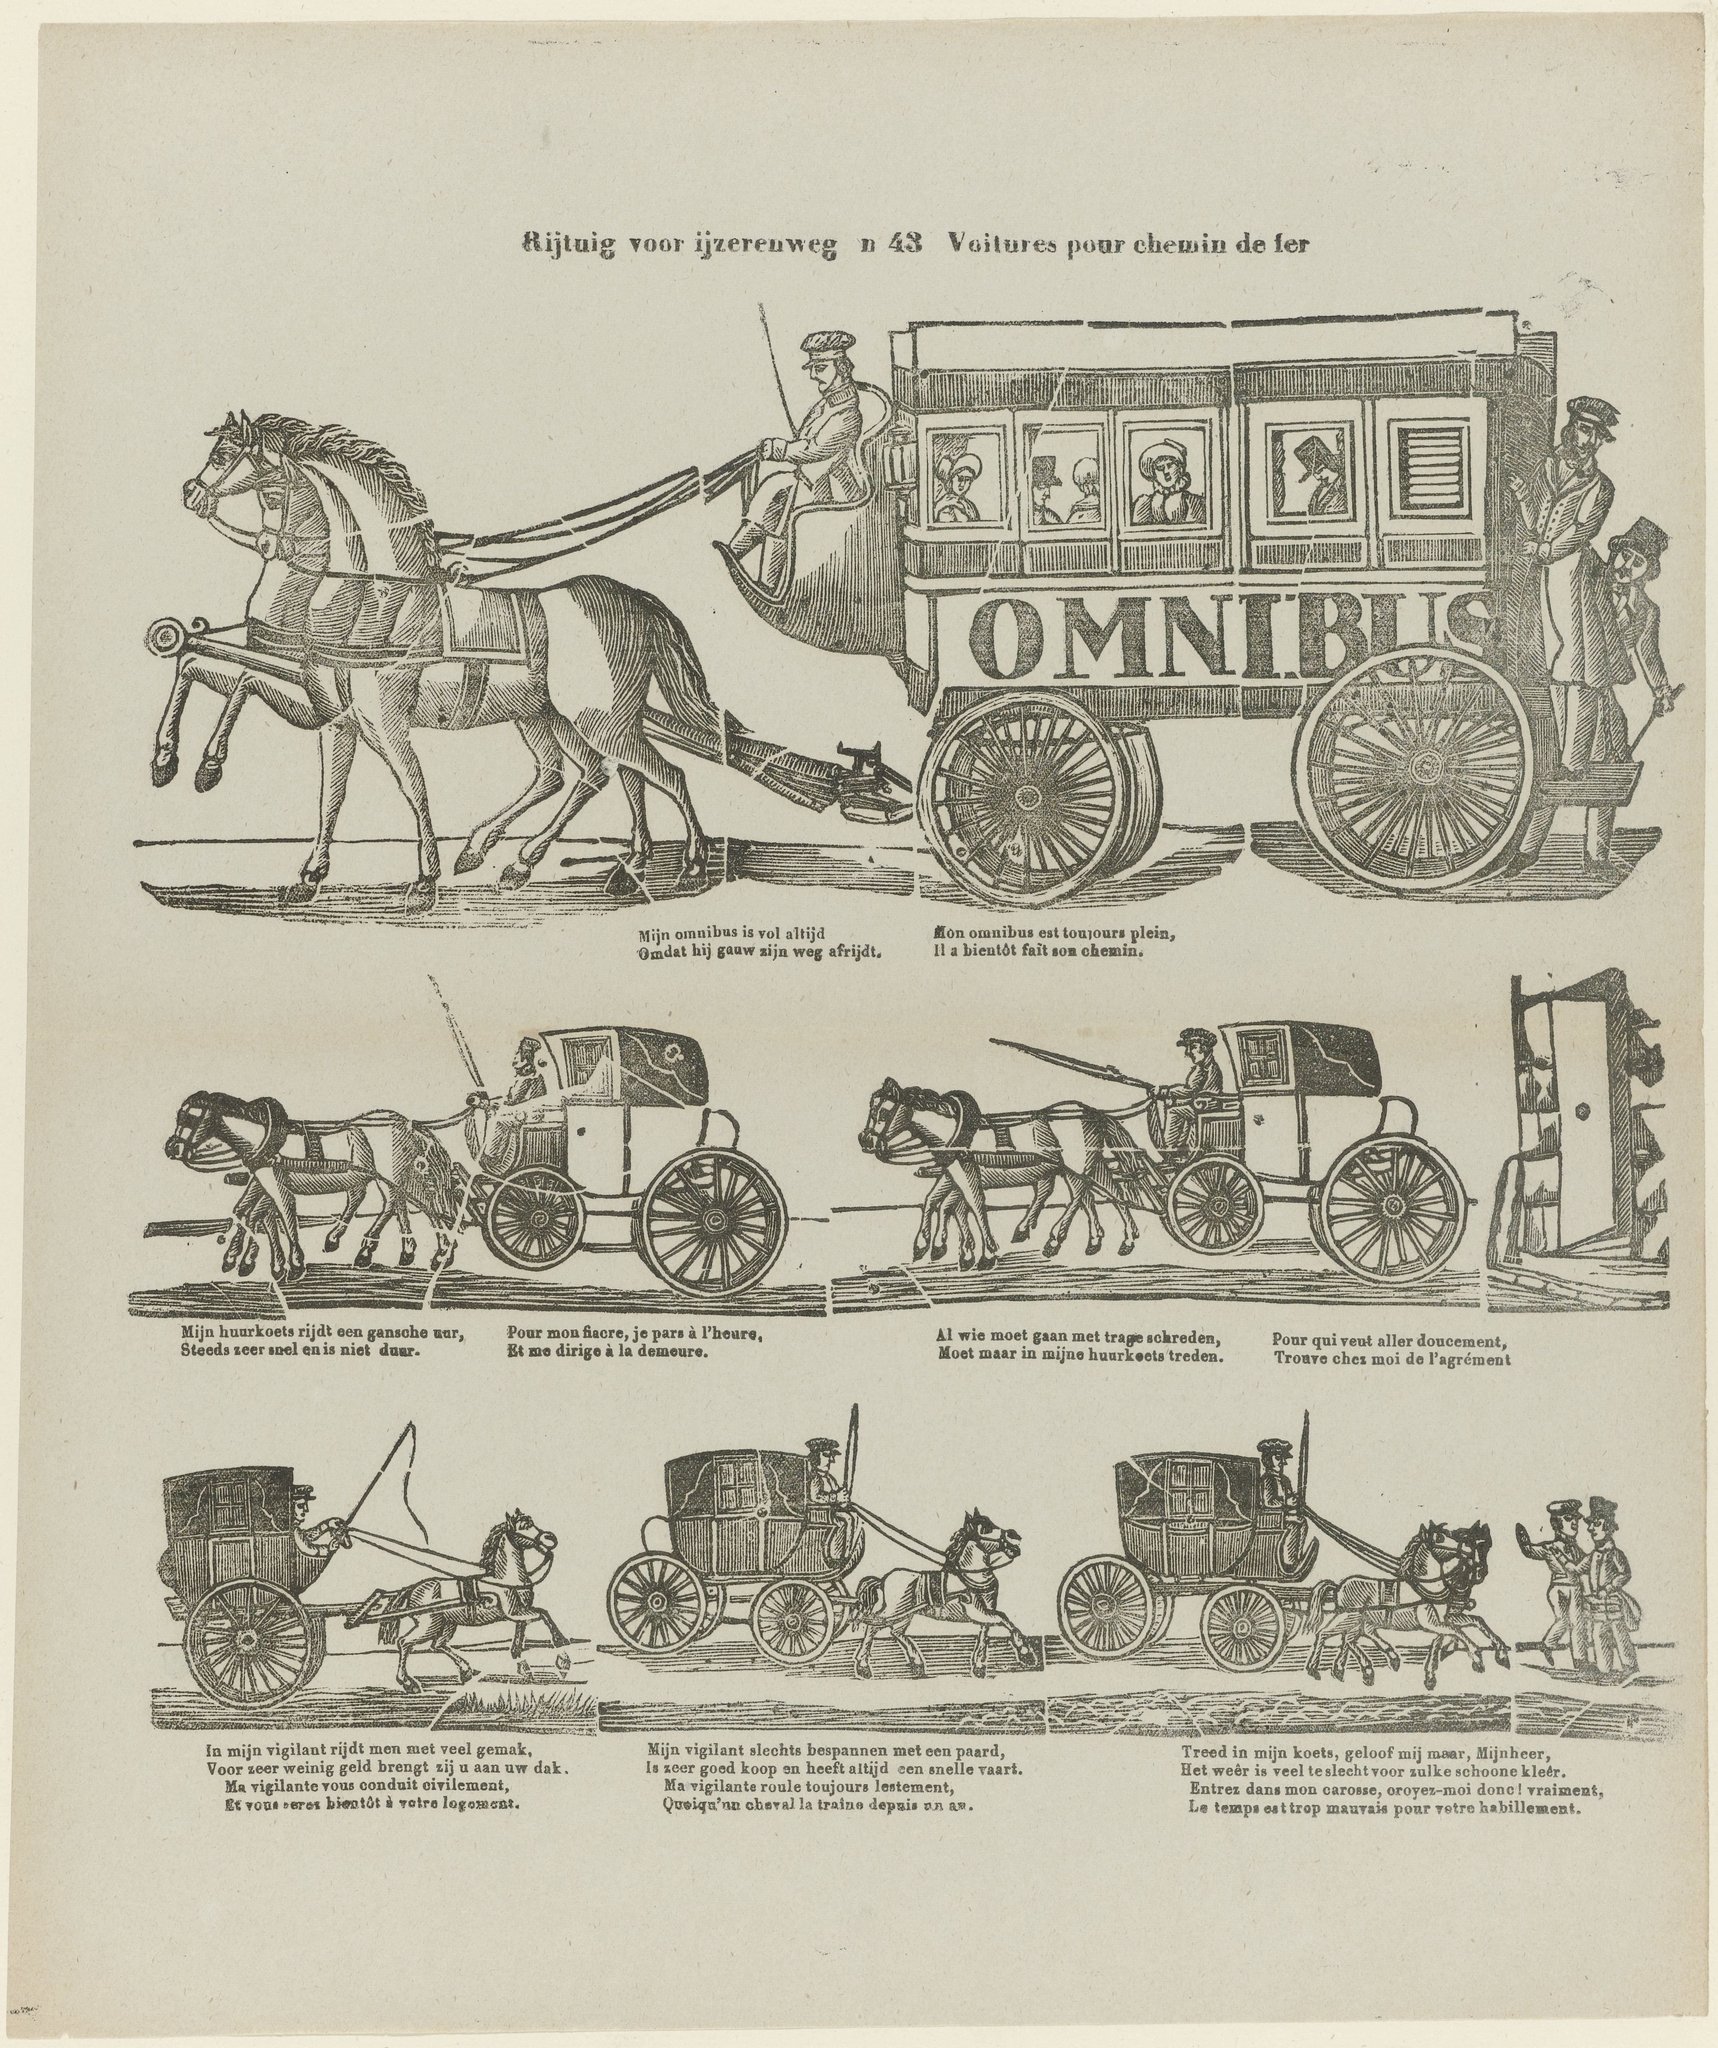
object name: popular print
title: Rijtuig voor ijzerenweg / Voitures pour chemin de fer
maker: Anonymous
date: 1856-1900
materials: paper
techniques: letterpress printing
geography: turnhout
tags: diligence, omnibus, horse-tram, four-wheeled, animal-drawn vehicle, e.g.: cab, carriage, coach, two-wheeled vehicle drawn by one animal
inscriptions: collector's mark: Lugt 2760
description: Blad met 8 voorstellingen van verschillende rijtuigen. Onder elke voorstelling een onderschrift in het Nederlands en in het Frans. Genummerd midden boven: n 43.